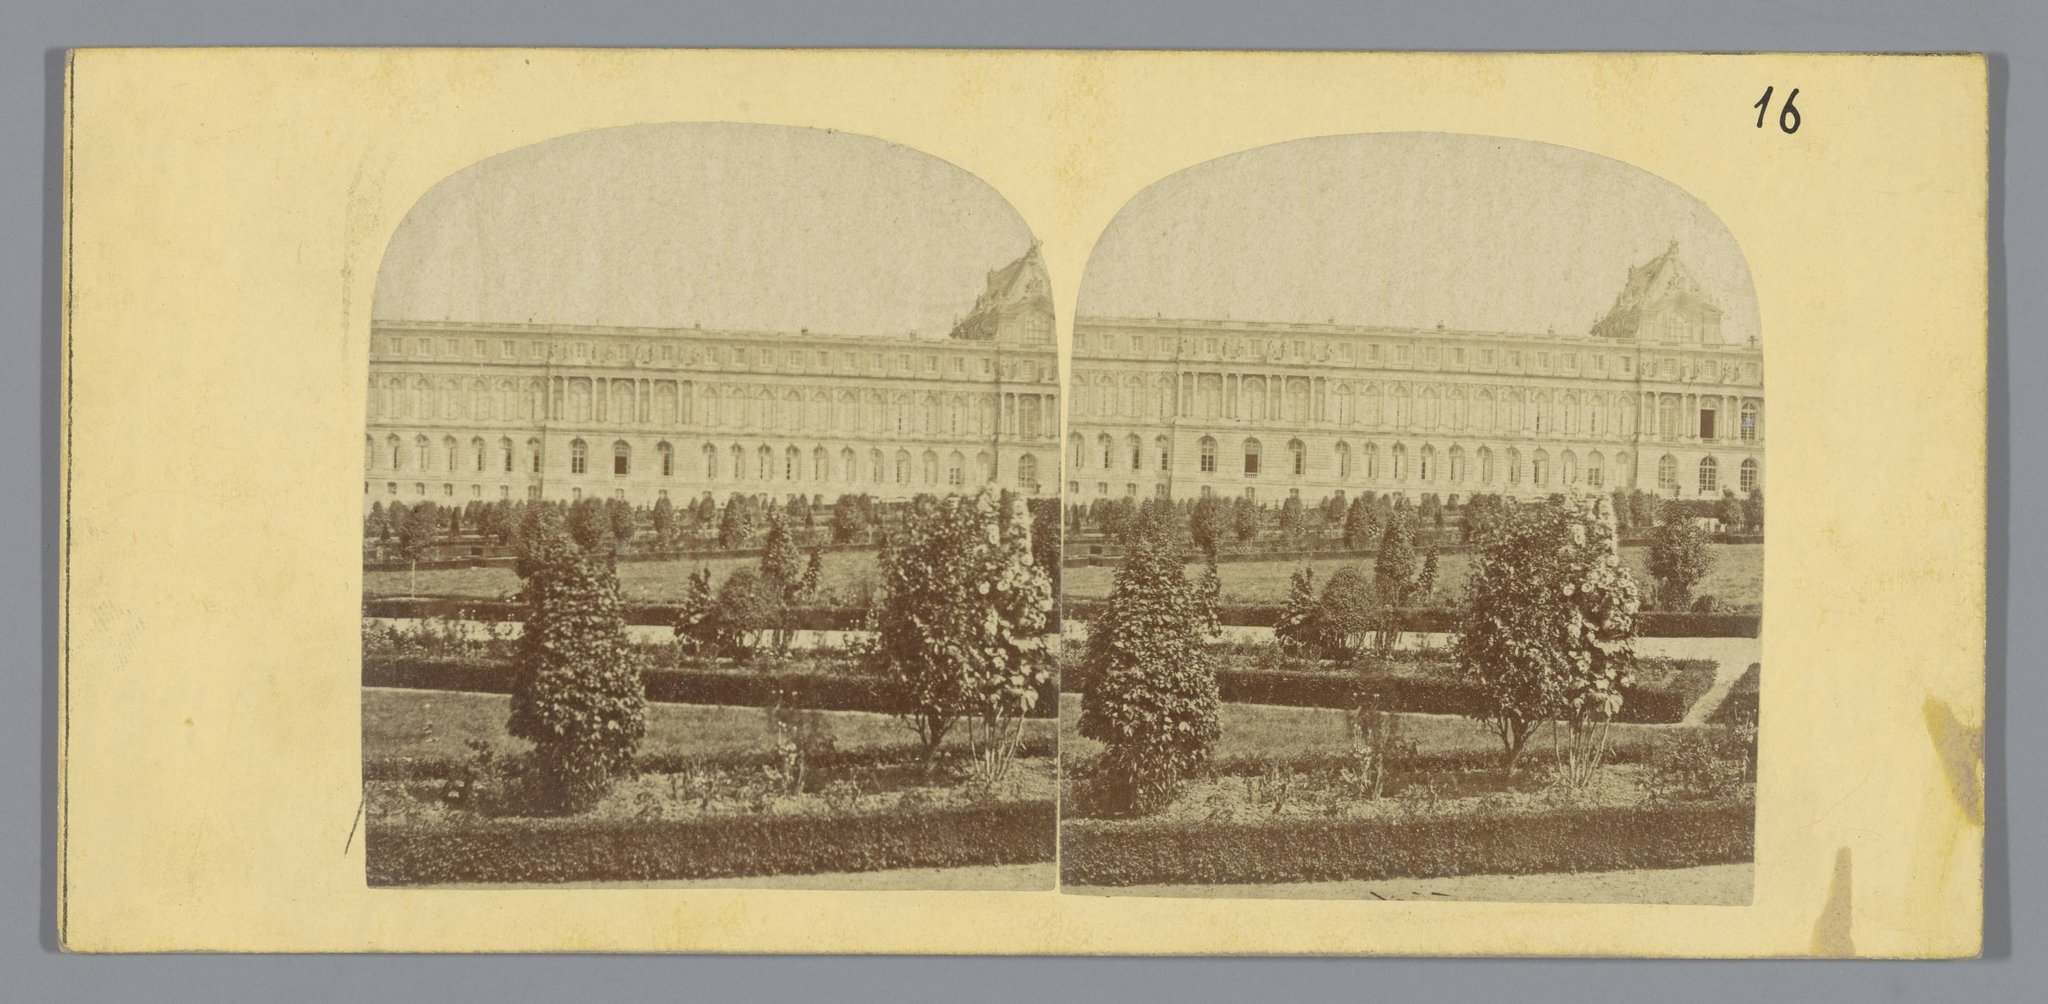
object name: stereograph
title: Paleis van Versailles, gezien vanuit de tuin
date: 1851-1880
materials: cardboard, paper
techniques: albumen print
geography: paris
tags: garden, palace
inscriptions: number: ‘16’, retailer's mark: ‘222, rue de Rivoli/ en face le Jardin des Tuileries./ Lecocq-Frêne/ Estampes Photographies/ Plans et Guides pour Voyageurs/ Vues pr Stéreoscopes.’